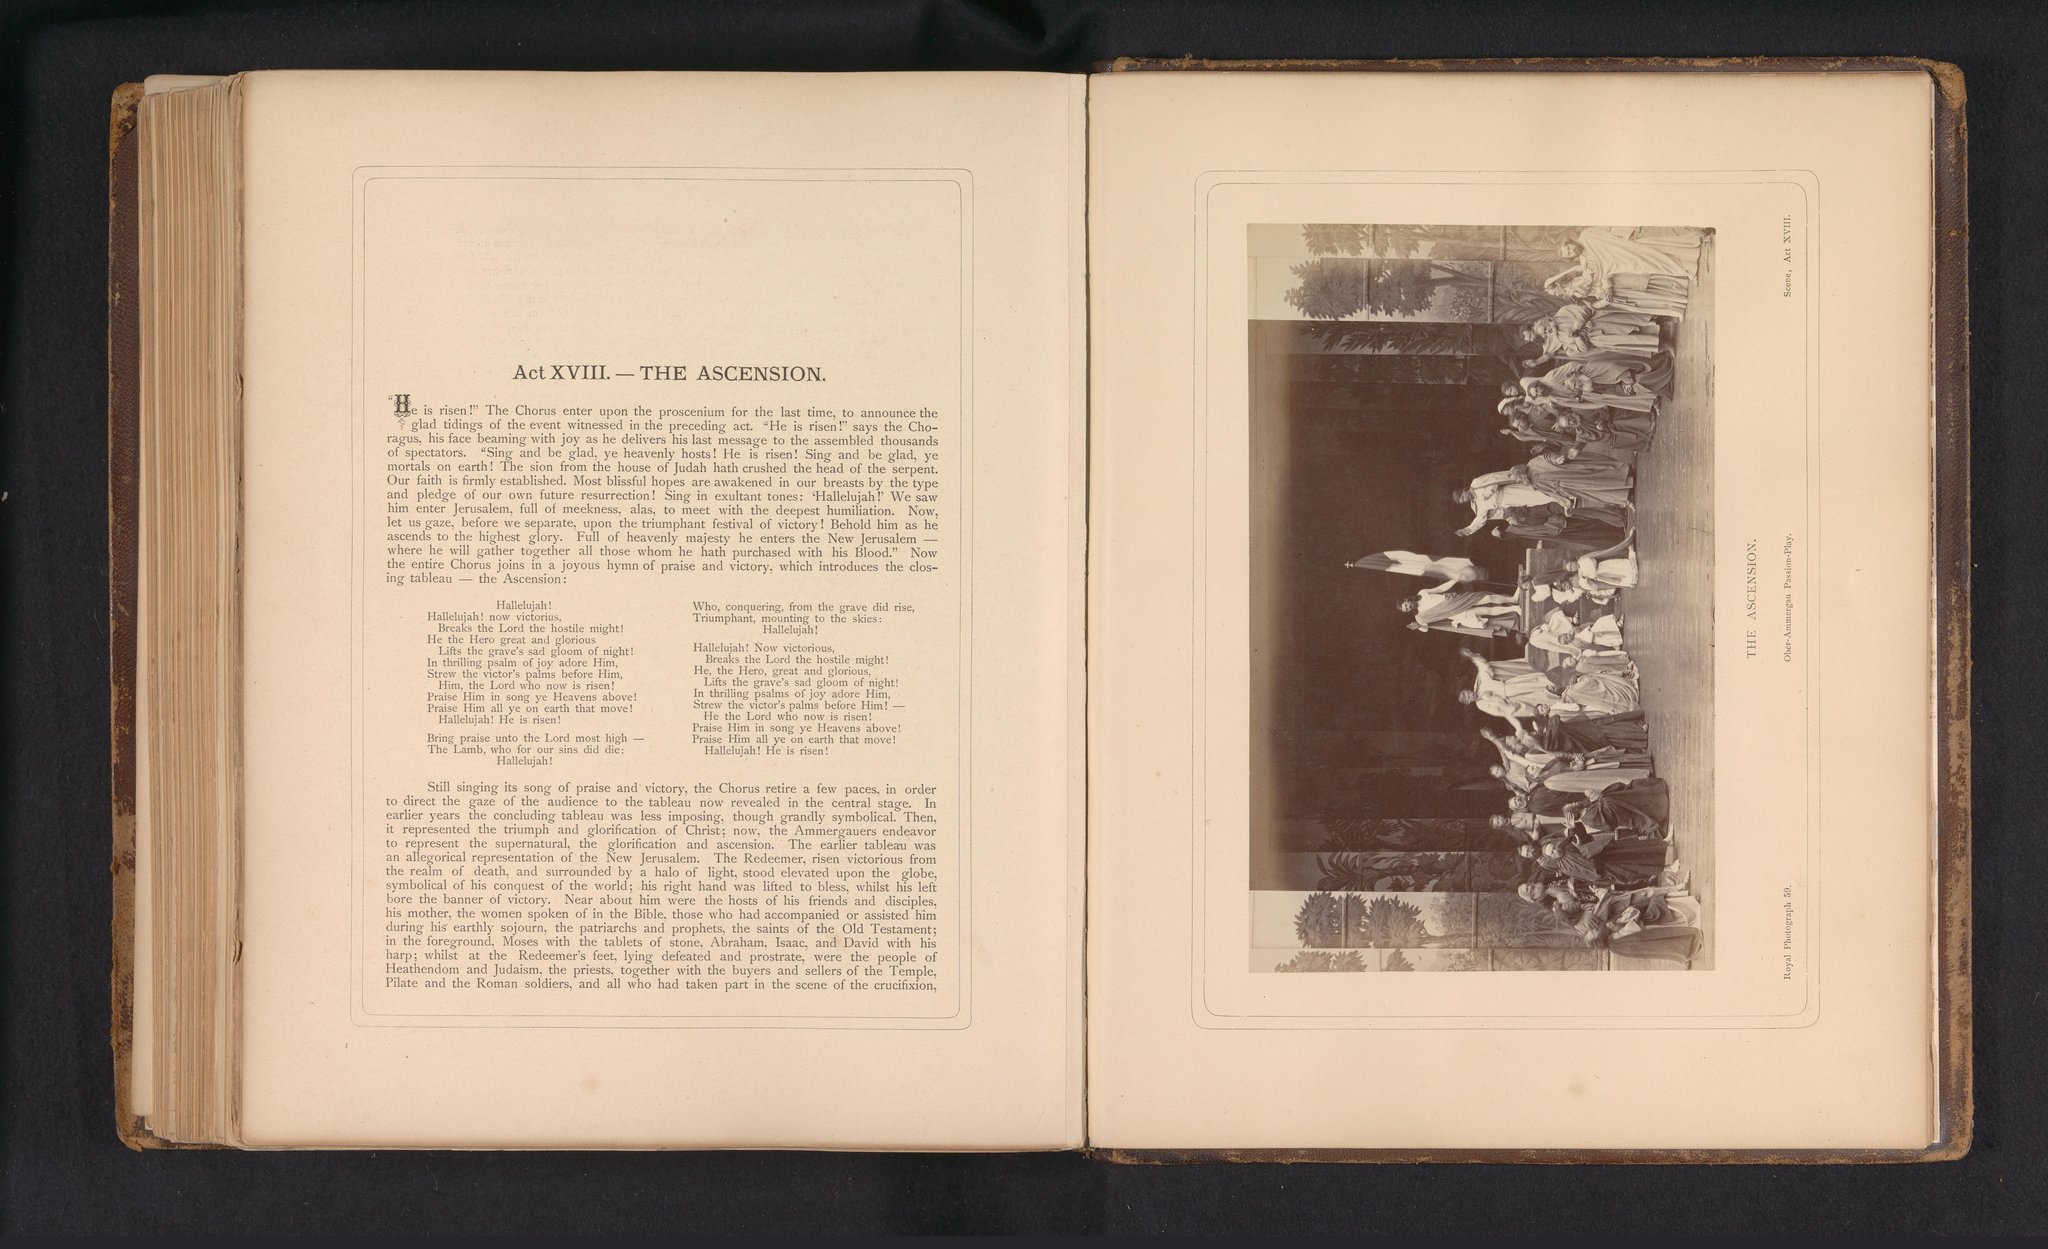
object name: photograph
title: The ascension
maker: joseph albert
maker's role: printer, publisher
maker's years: 1825-1886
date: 1868-1873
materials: photographic support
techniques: albumen print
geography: oberammergau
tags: the ascension (christ surrounded by radiant light or in a mandorla), group of actors, troupe; actors on the stage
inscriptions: number: ‘Royal Photograph 59.’